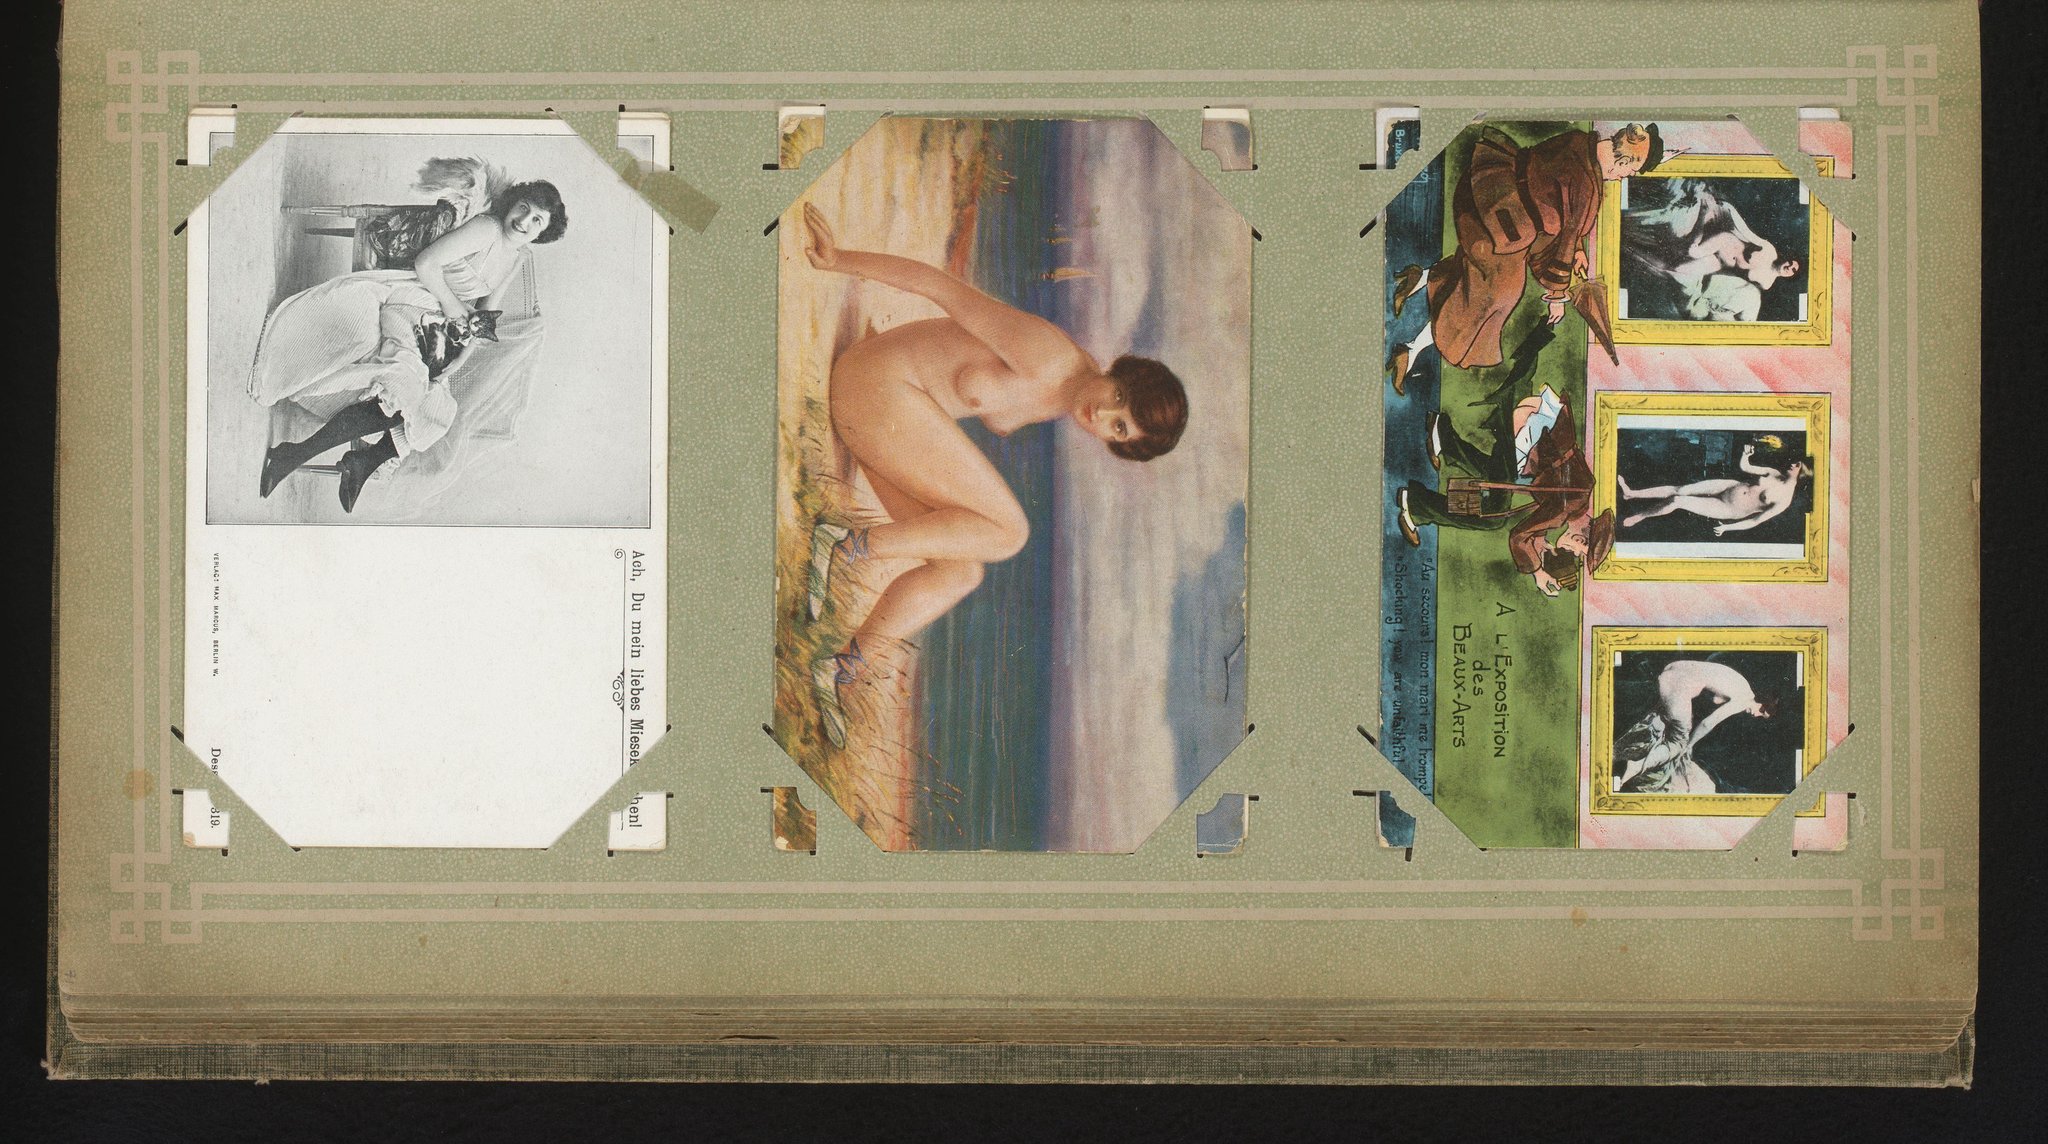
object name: photomechanical print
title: Twee reproducties van ontwerpen met naakte vrouwen en een portret van een zittende vrouw met een kat op schoot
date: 1900-1930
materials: cardboard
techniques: chromolithography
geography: berlin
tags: adult man (+ two persons), cat, historical persons - bb - woman, woman (showing herself) undressed, quasi-nude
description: Een reproductie van een tekening van twee mannen die kijken naar drie foto's van naakte vrouwen aan een wand en een reproductie van een geschilderd portret van een zittende naakte vrouw op het strand. Deze prenten maken deel uit van een album.